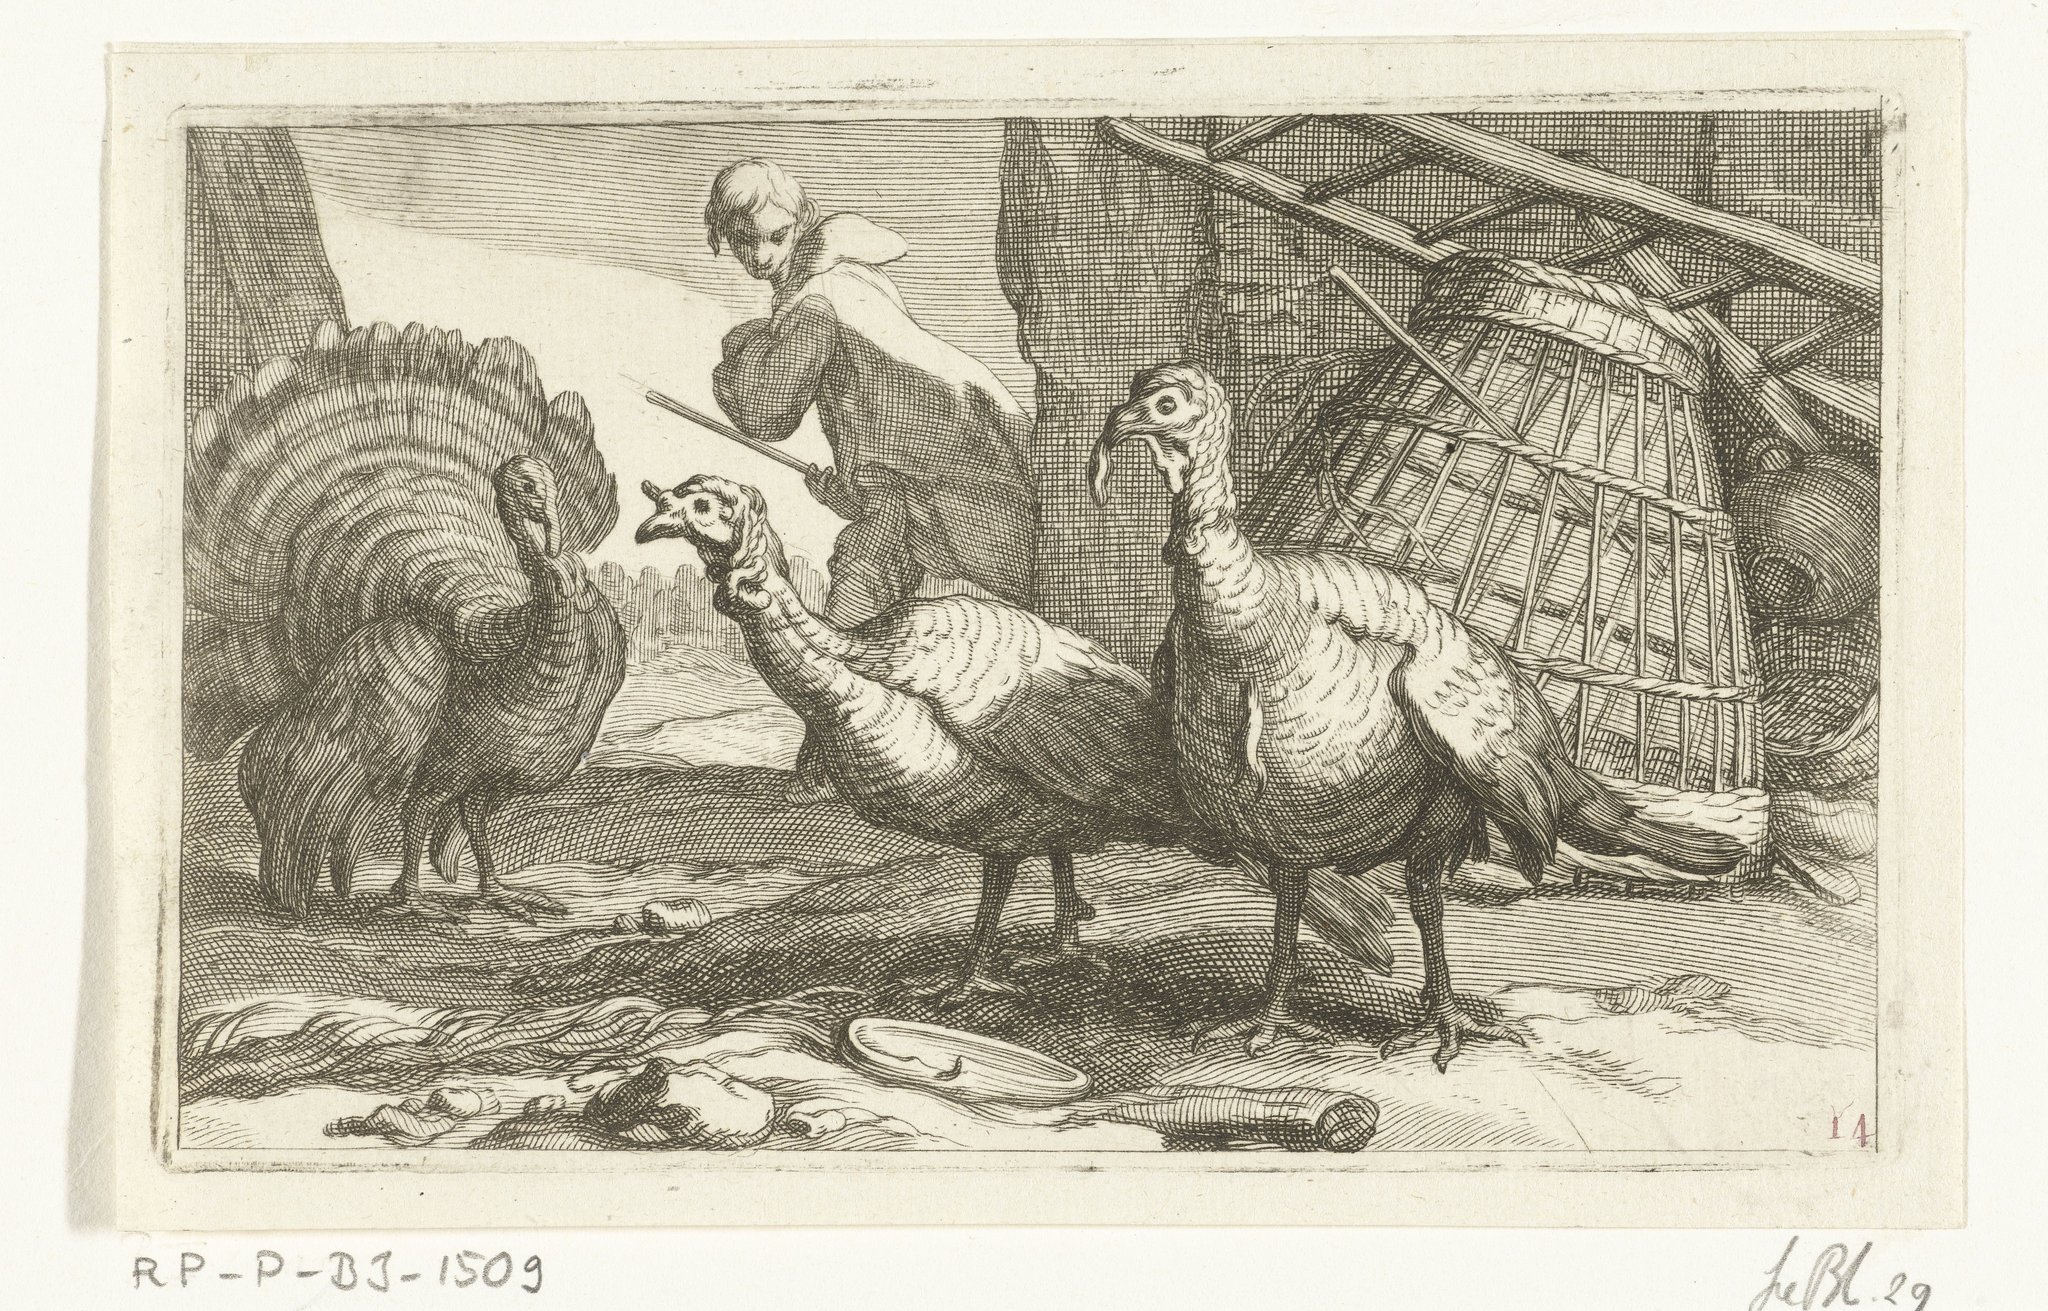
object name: print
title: Dieren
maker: frederick bloemaert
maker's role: print maker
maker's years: 1614-1669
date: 1635-1670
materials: paper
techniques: engraving, etching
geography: utrecht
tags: walker and runner birds: turkey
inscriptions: number: ‘14’, collector's mark: Lugt 240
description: Drie kalkoenen dwalen rond op een boerenerf. Prent uit een serie van 14 prenten met verschillende inheemse dieren.